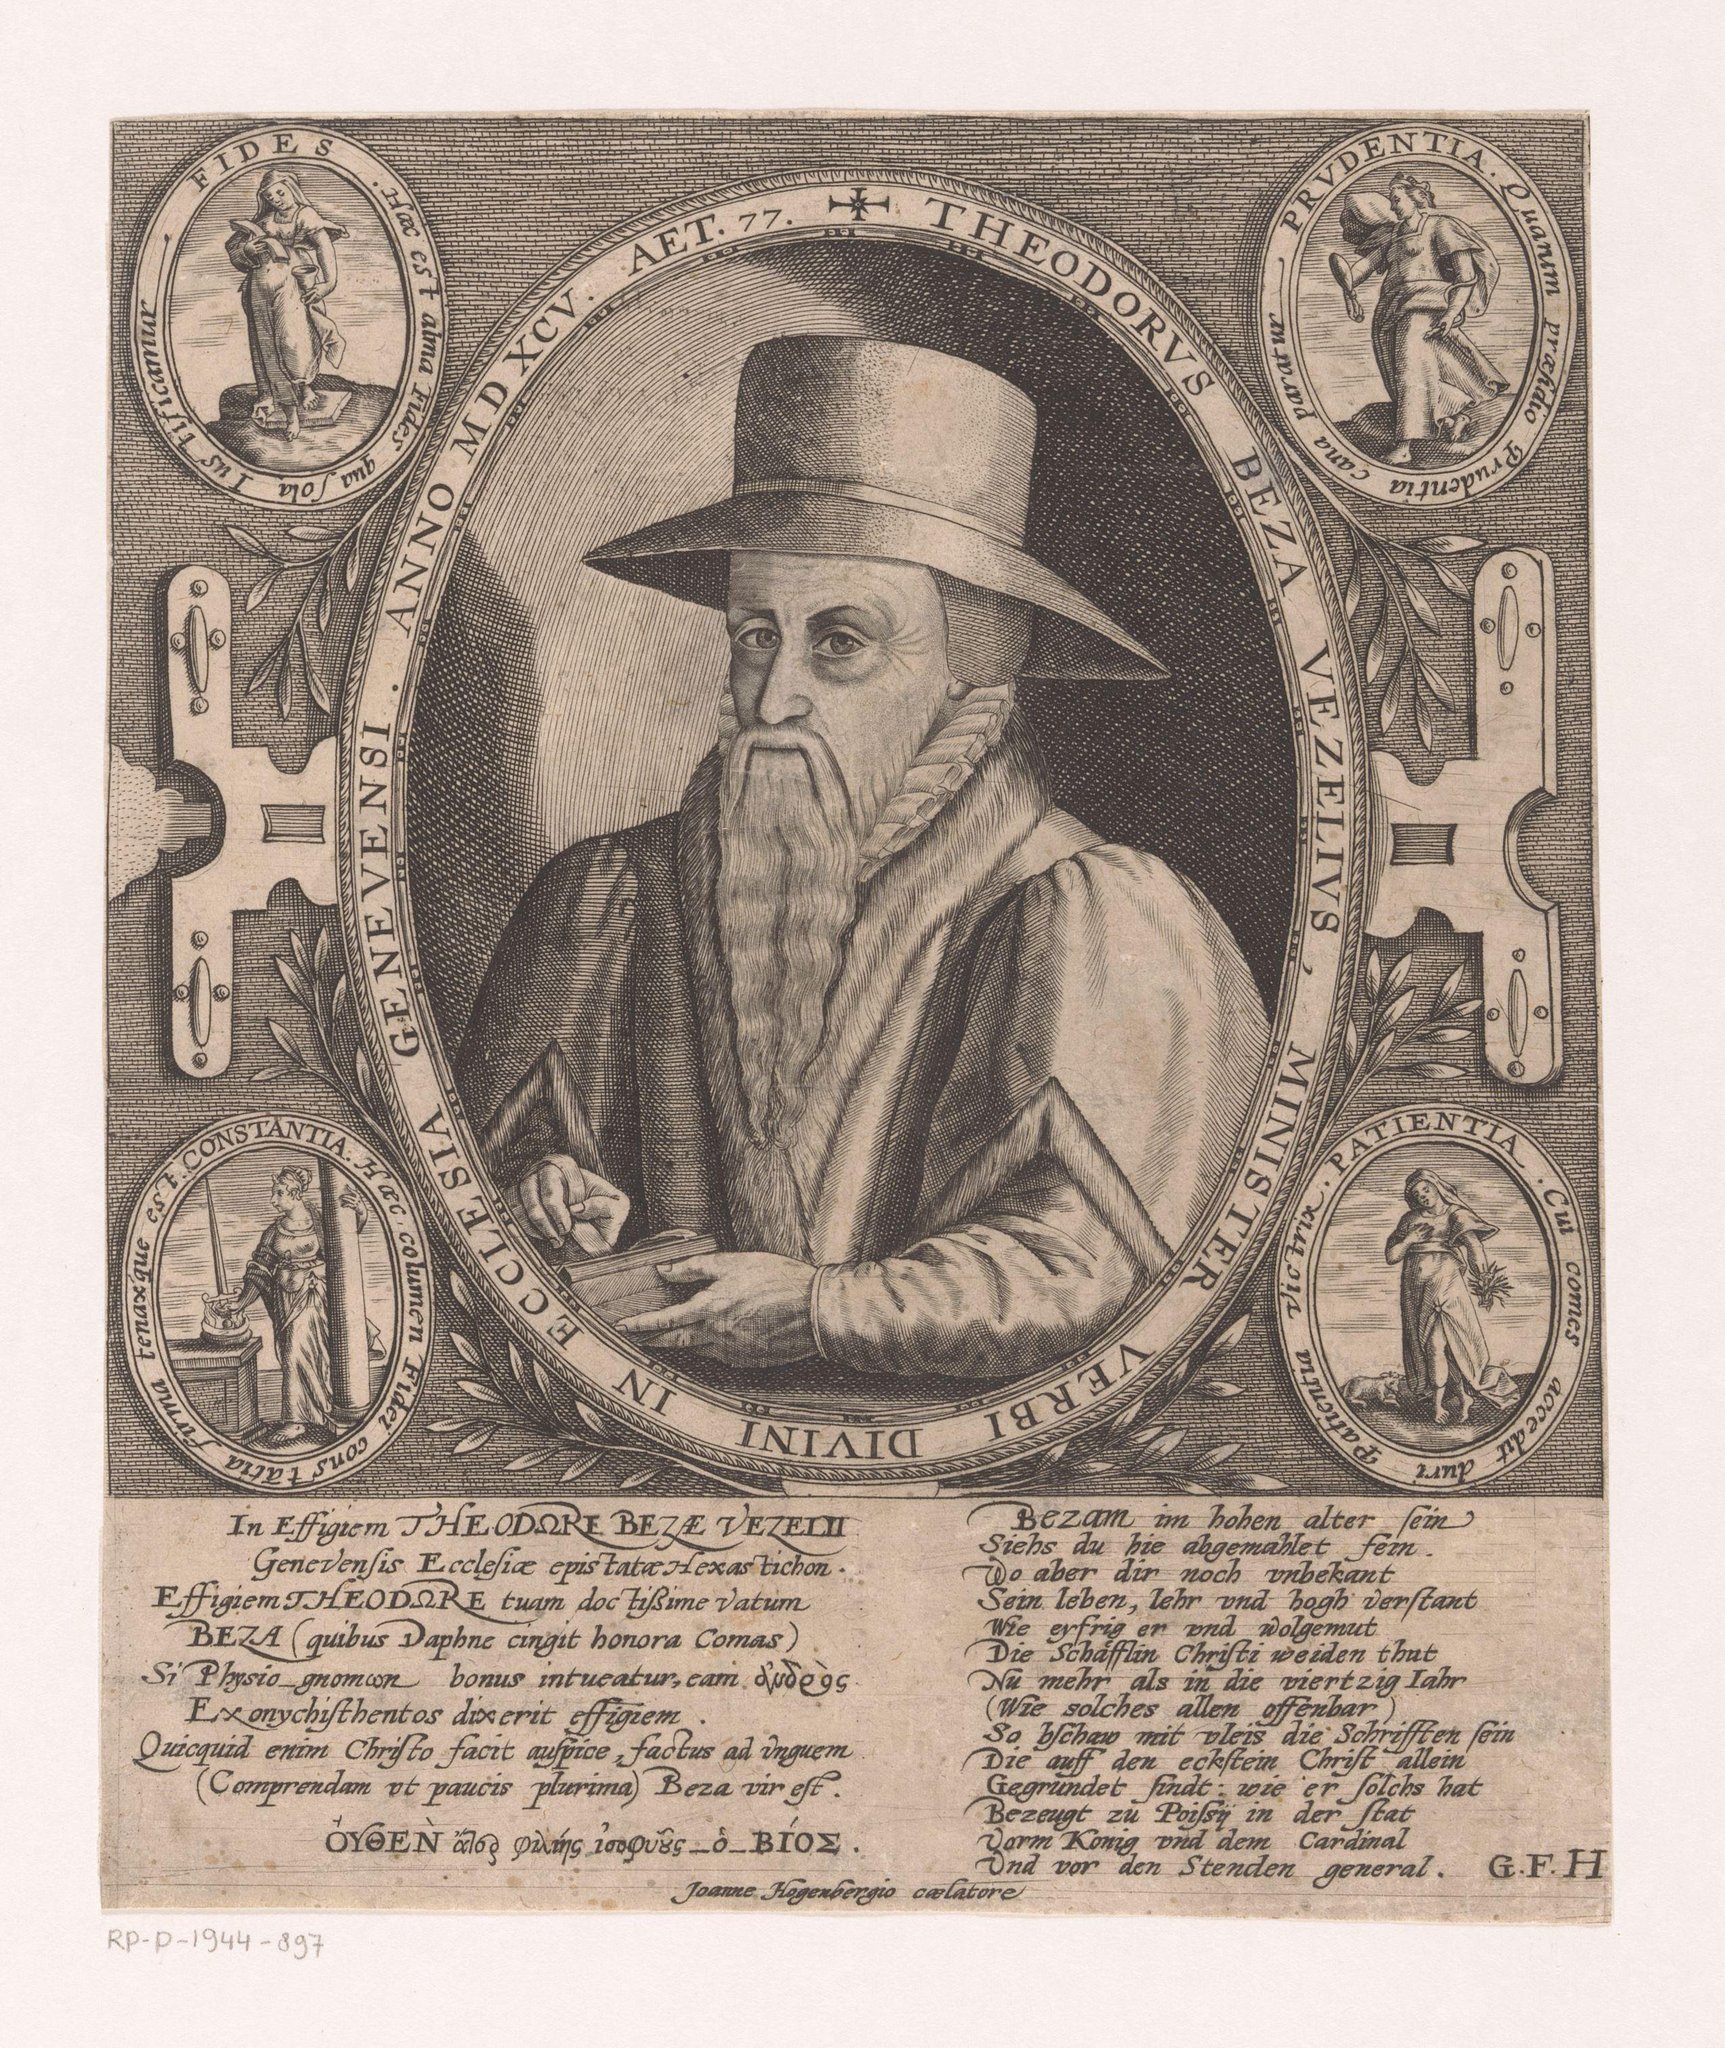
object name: print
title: Portret van Theodor Beza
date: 1595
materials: paper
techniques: engraving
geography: germany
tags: theodorus beza, ornament ~ medallion, historical persons, ornament ~ cartouche, ornament derived from architectural details, the four cardinal virtues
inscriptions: collector's mark: Lugt 2228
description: Rondom vier medaillons met deugden. Tekst in het Latijn in de omlijsting van het medaillon en in de marge eronder, met ook enkele woorden in het Grieks.